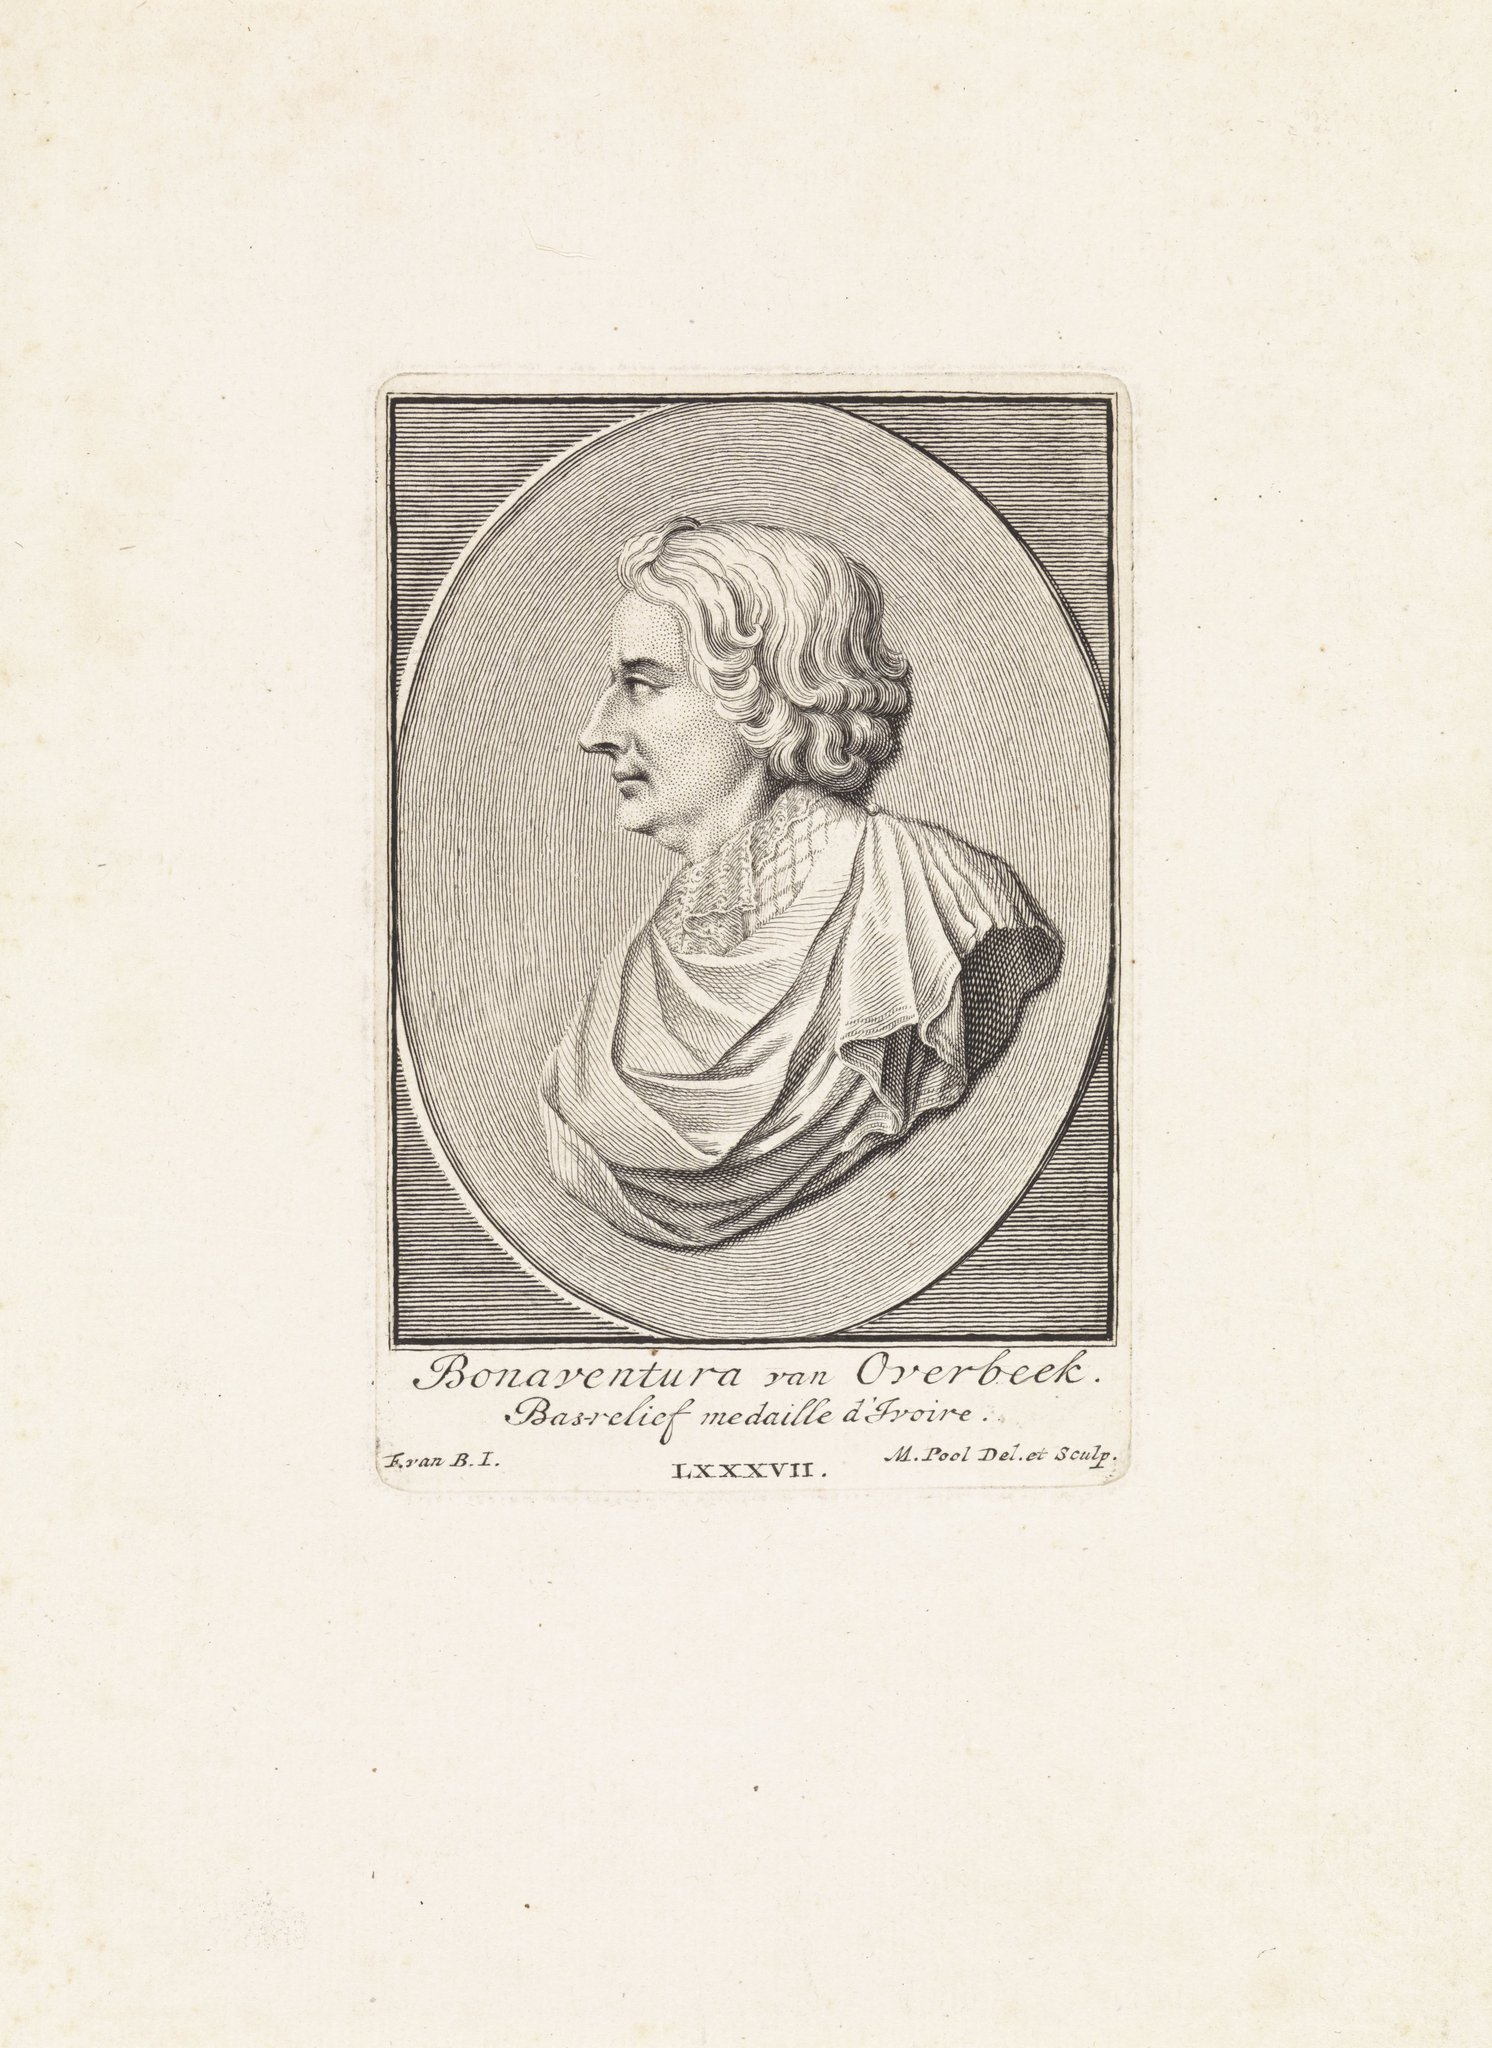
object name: print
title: Bas-reliëf met het portret van Bonaventura van Overbeek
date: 1727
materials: paper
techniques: engraving, etching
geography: amsterdam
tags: amsterdam, print maker, draughtsman, bonaventura van overbeek, piece of sculpture, reproduction of a piece of sculpture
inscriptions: collector's mark: Lugt 2228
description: Prent ook gebruikt in: Bossuit, Francis van. Cabinet de l'art de schulpture (...). Executé en yvoire (...). = Beeld-snyders kunst-kabinet (...). = Statues, or Art's cabinet. Amsterdam: M. Pool, 1727.